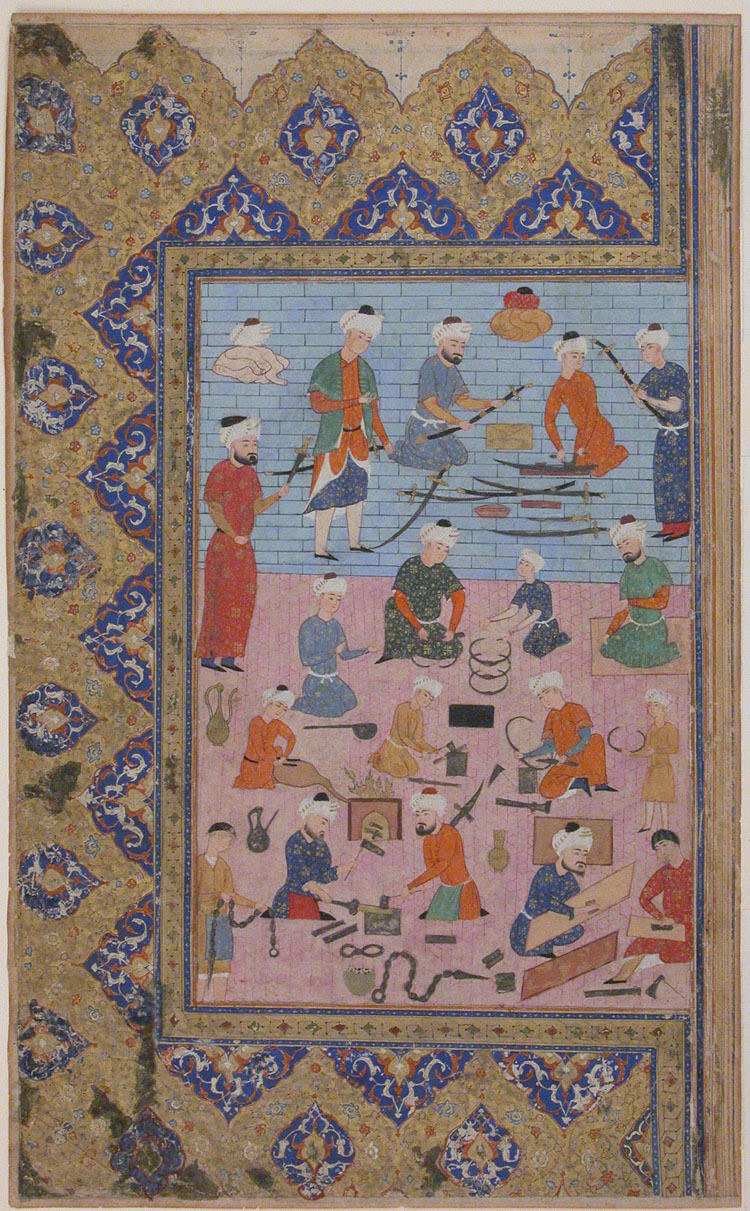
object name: folio from an illustrated manuscript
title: An Arms Workshop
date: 1534-1566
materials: gold, ink, paper, watercolor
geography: iran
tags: weapons,men,working